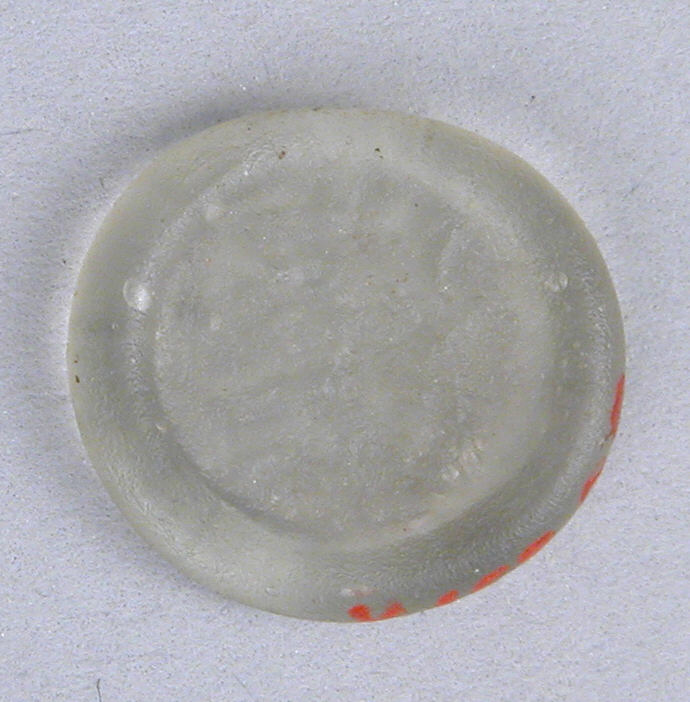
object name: coin weight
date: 1001-1100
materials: glass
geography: egypt